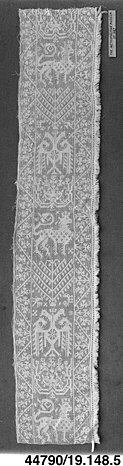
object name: strip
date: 1501-1700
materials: linen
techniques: embroidery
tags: animals